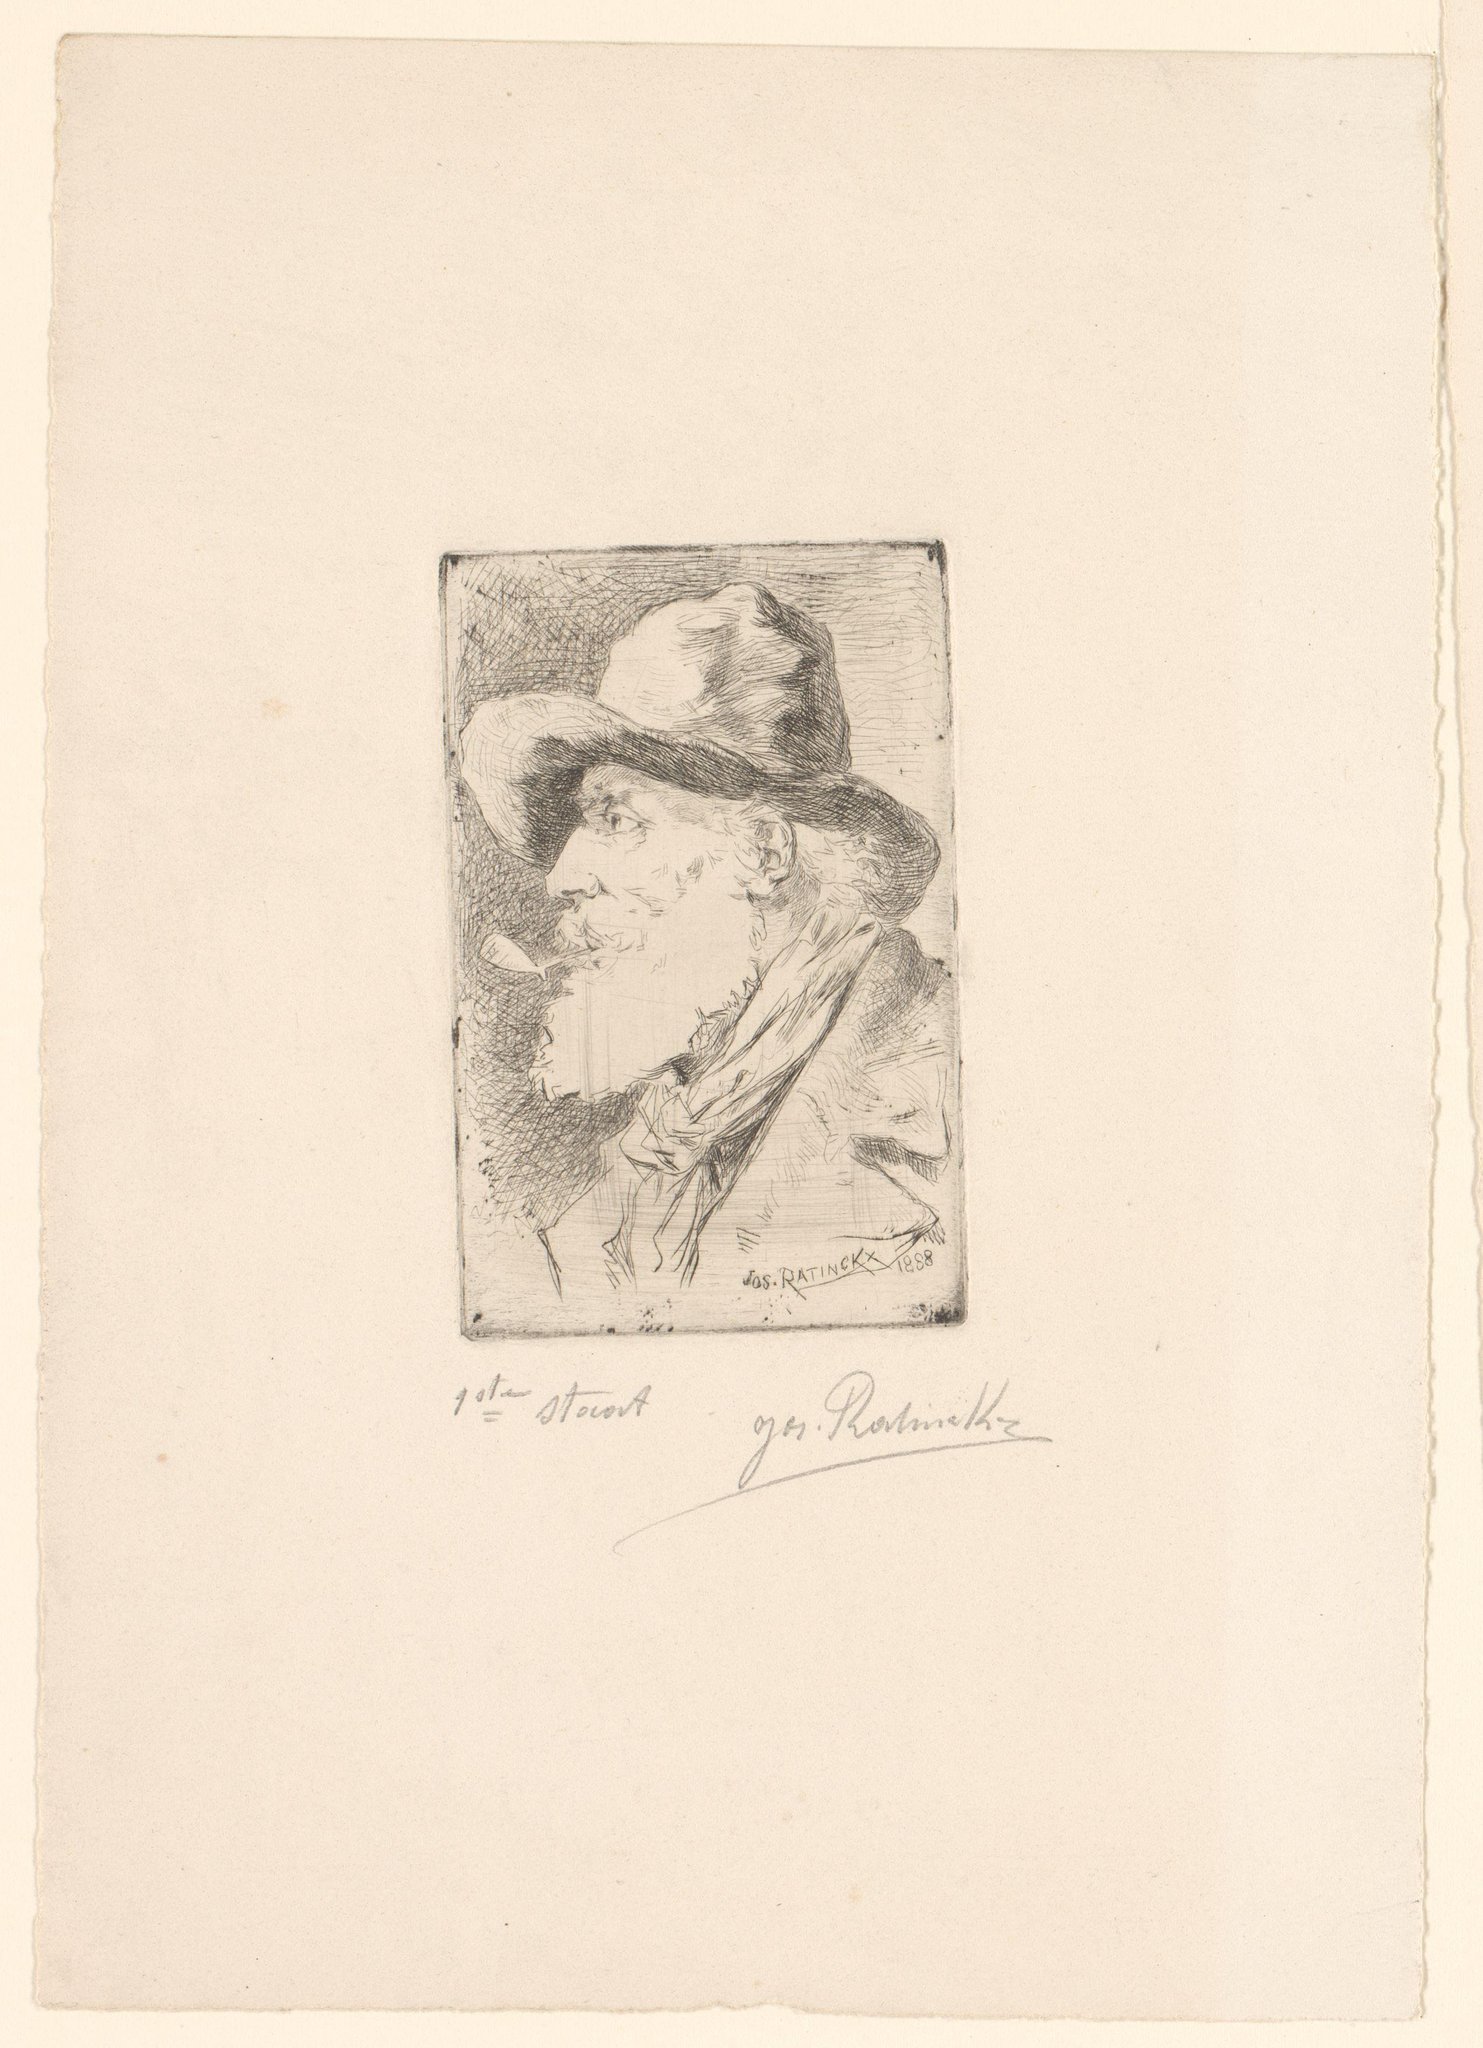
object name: print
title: Pijprokende oude man met hoed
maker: jos ratinckx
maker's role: print maker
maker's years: 1860-1937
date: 1888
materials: paper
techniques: etching, intaglio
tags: head-gear, pipe ~ tobacco, old man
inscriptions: collector's mark: Lugt 2228, inscription: ‘1ste staat’